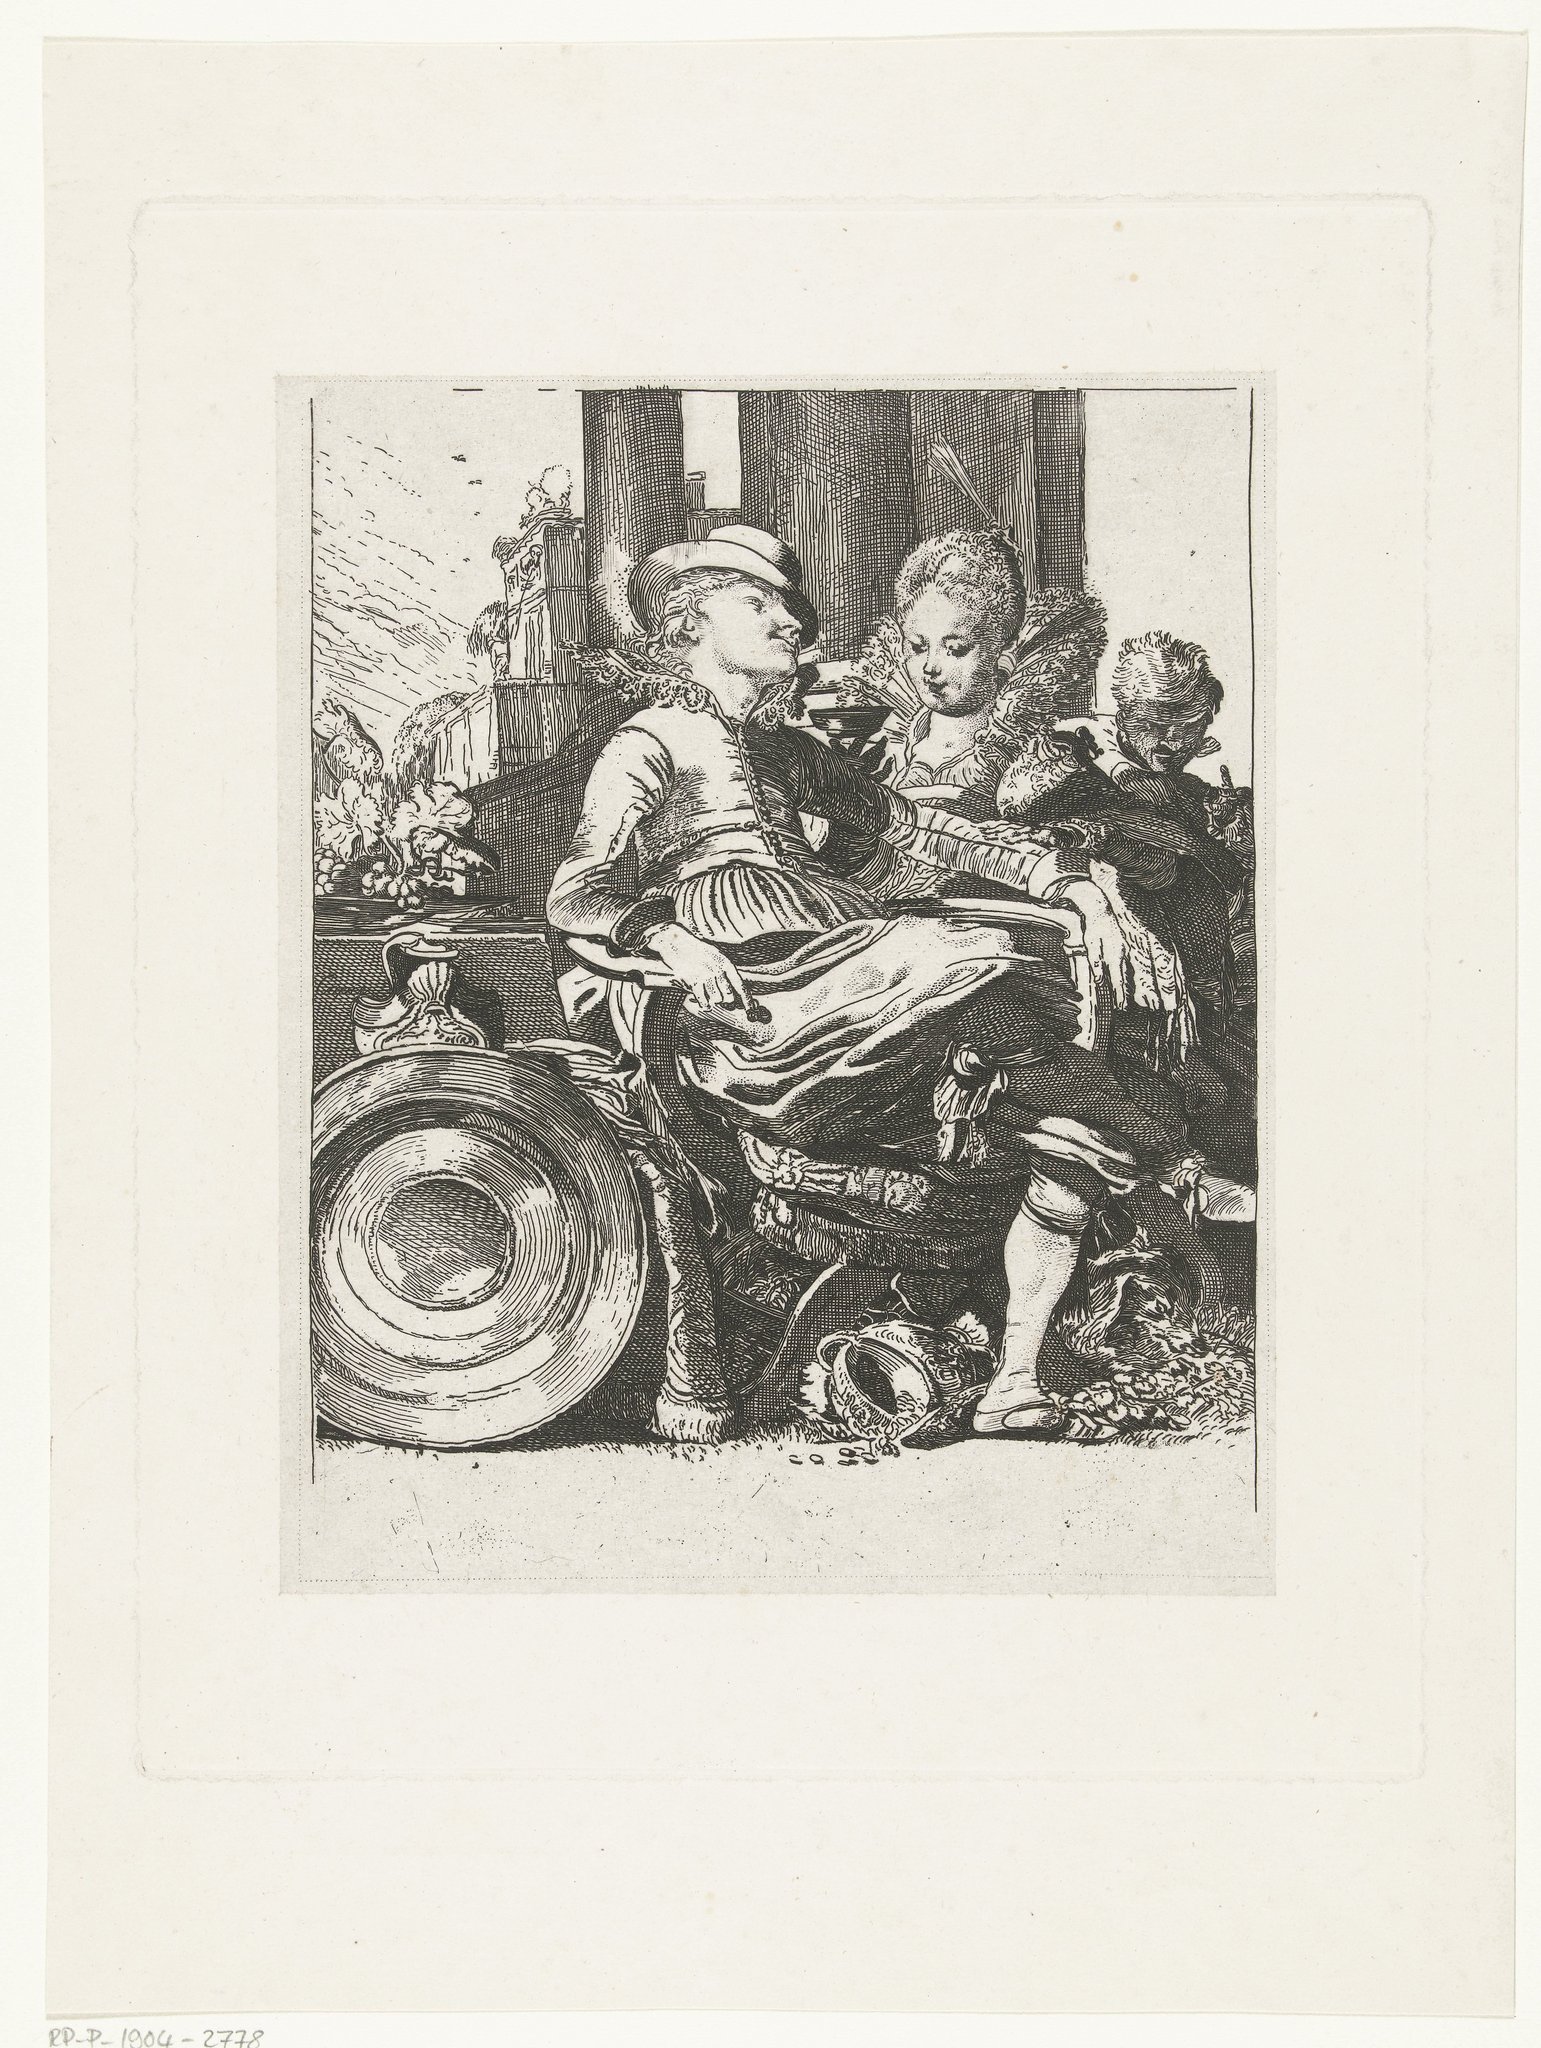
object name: print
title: Het verliefde paar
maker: johannes arnoldus boland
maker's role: print maker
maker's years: 1838-1922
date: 1866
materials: paper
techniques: etching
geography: amsterdam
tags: (scenes from) specific works of literature: bredero, lucelle, couple of lovers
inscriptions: collector's mark: Lugt 2228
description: Illustratie voor J.P. van der Kellen, Le peintre graveur hollandais et flamand, Utrecht: 1866.